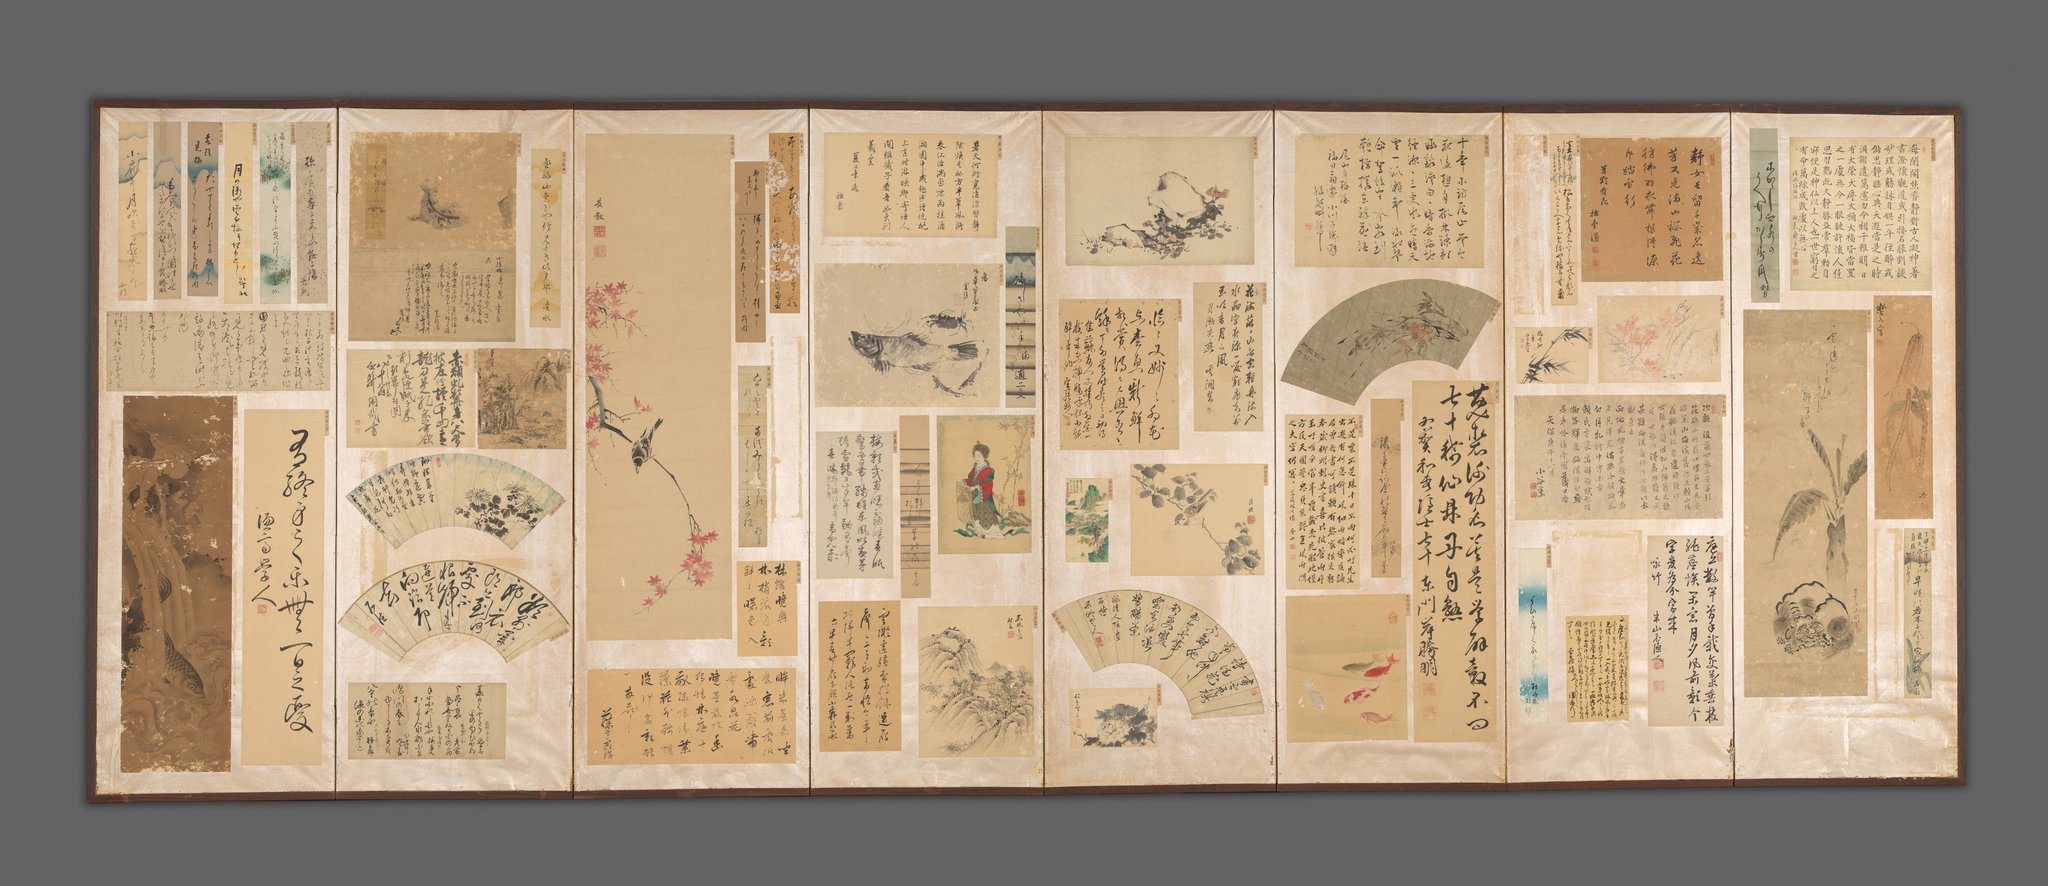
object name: screen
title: Paintings and Calligraphy by Literati of Iga Ueno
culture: japanese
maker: fifty-six artists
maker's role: artist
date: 1801-1833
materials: ink, panel, paper, silk